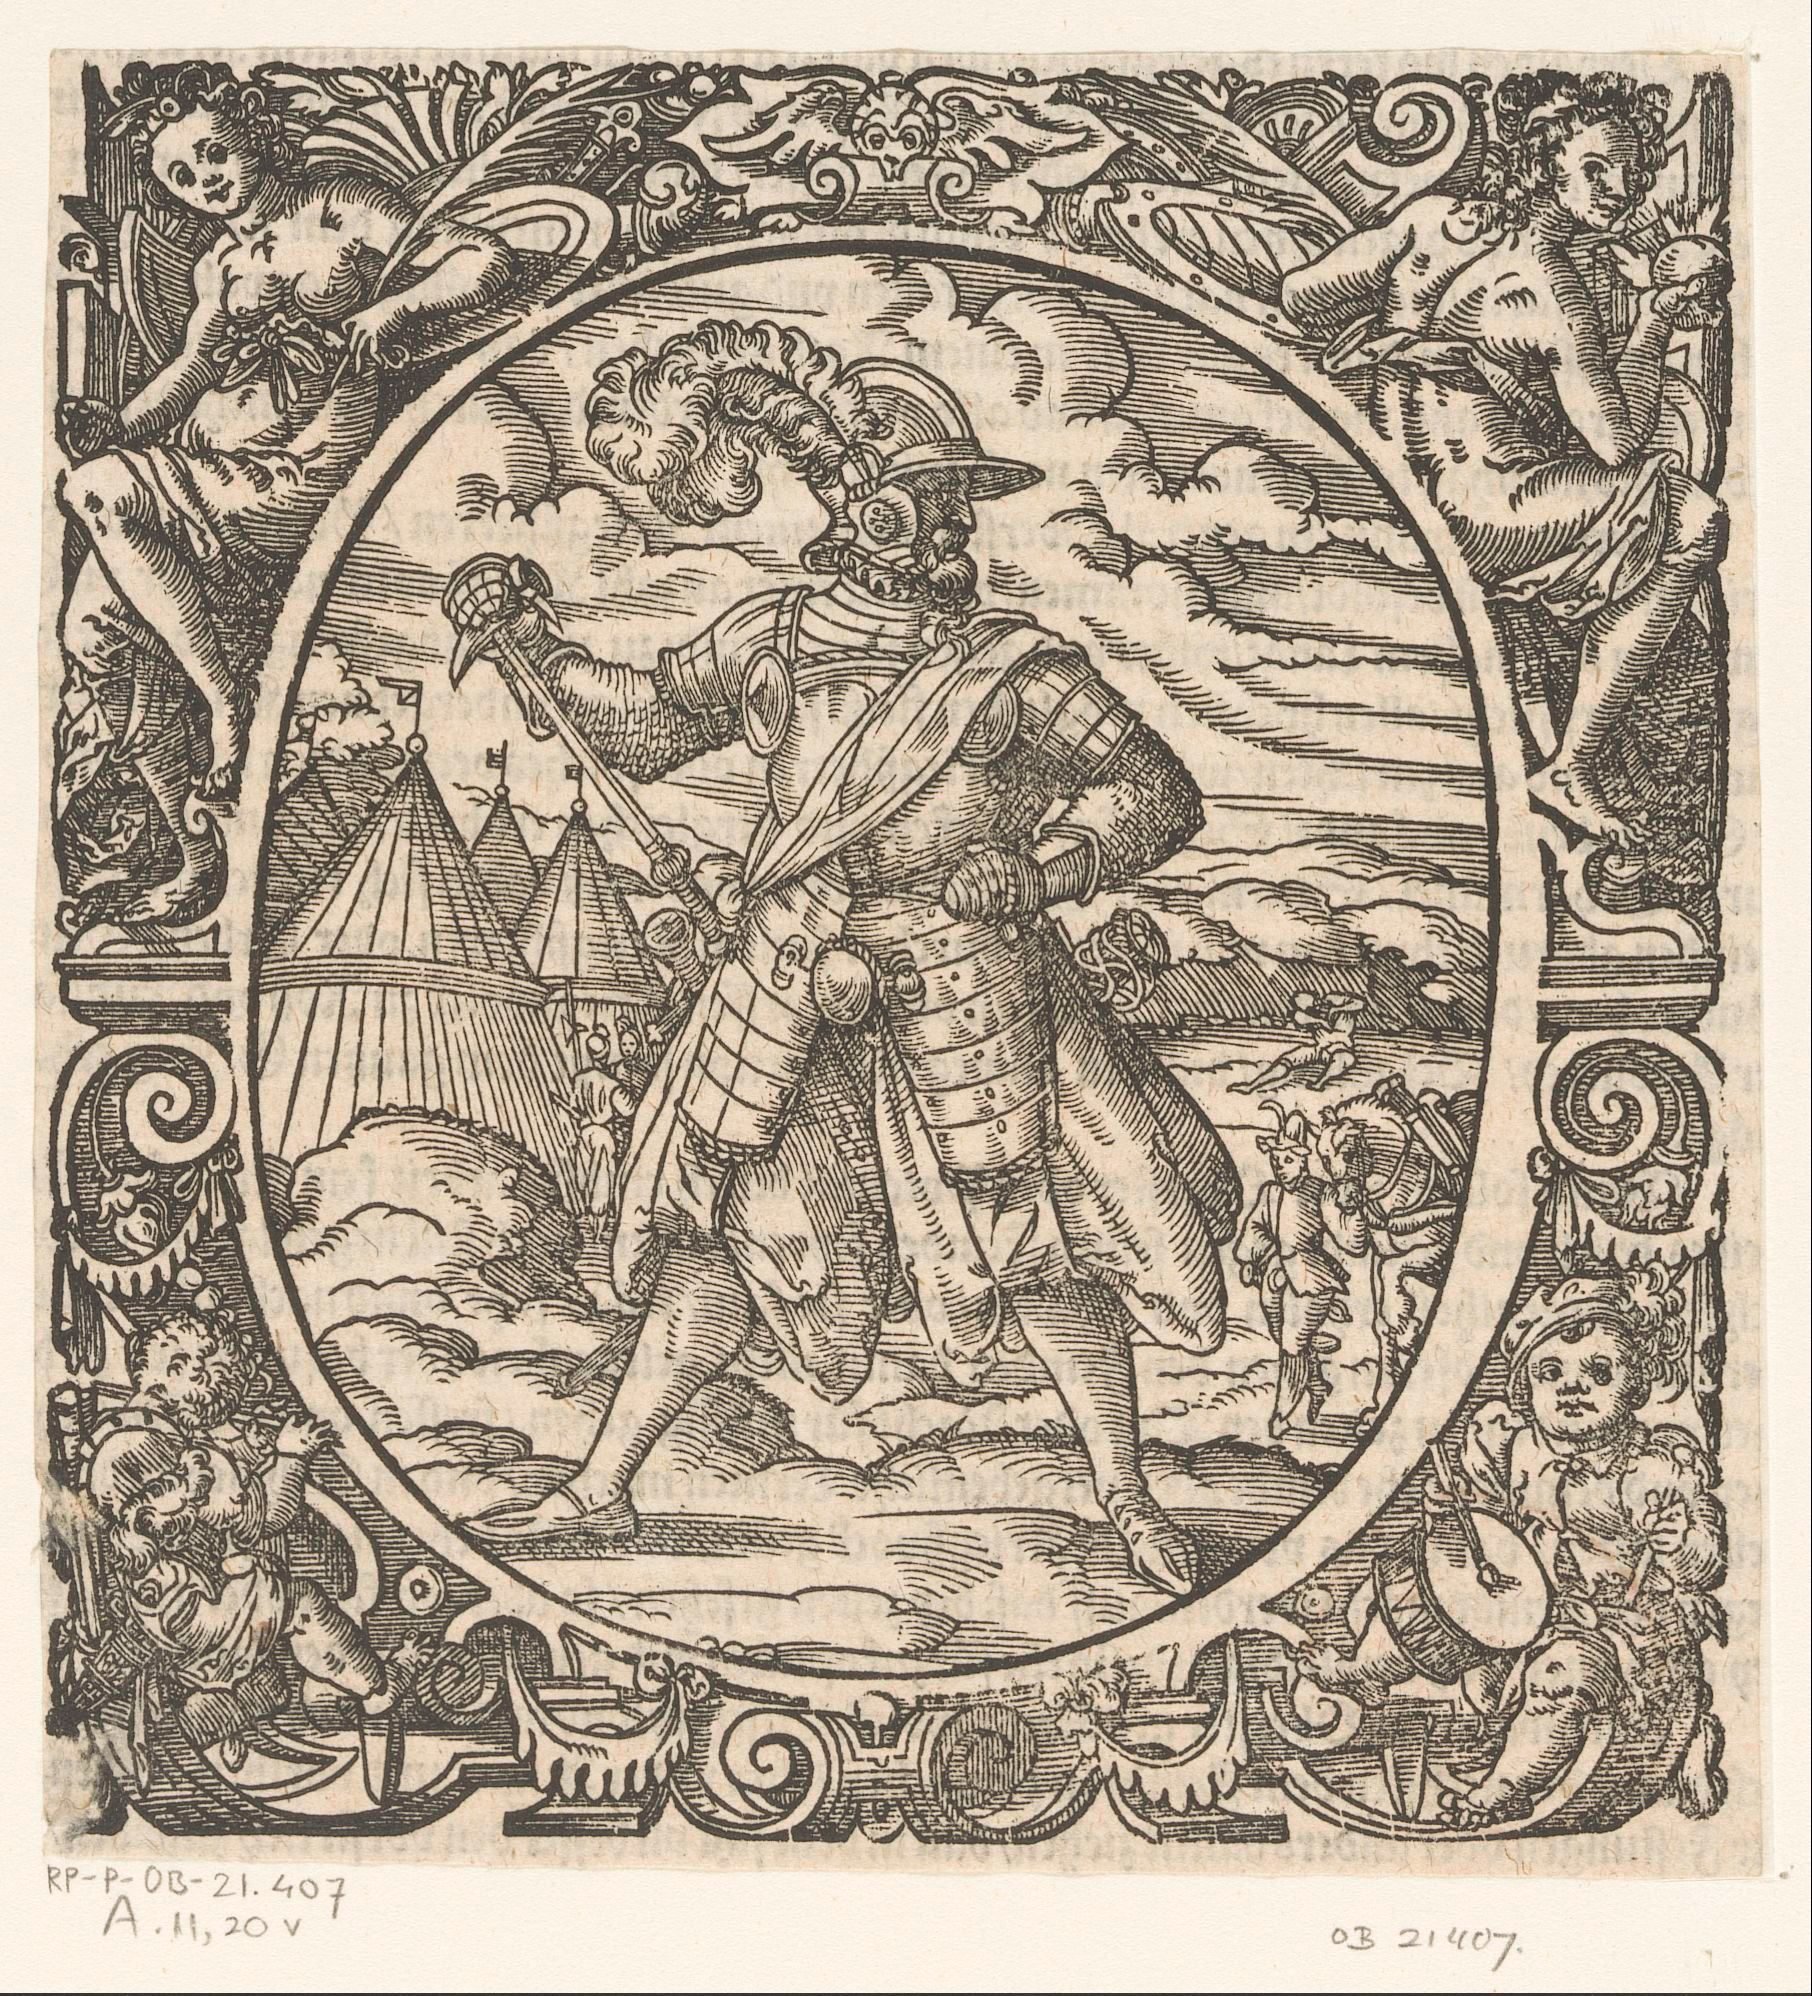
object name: print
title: Officier voor een tentenkamp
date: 1573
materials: paper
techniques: woodcut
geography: nuremberg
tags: (military) camp with tents, warfare; military affairs, officer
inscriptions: collector's mark: Lugt 240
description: Zowel de voorstelling als de ornamentrand werd gebruikt voor verschillende edities van Leonhardt Fronspergers Kriegsbuch.